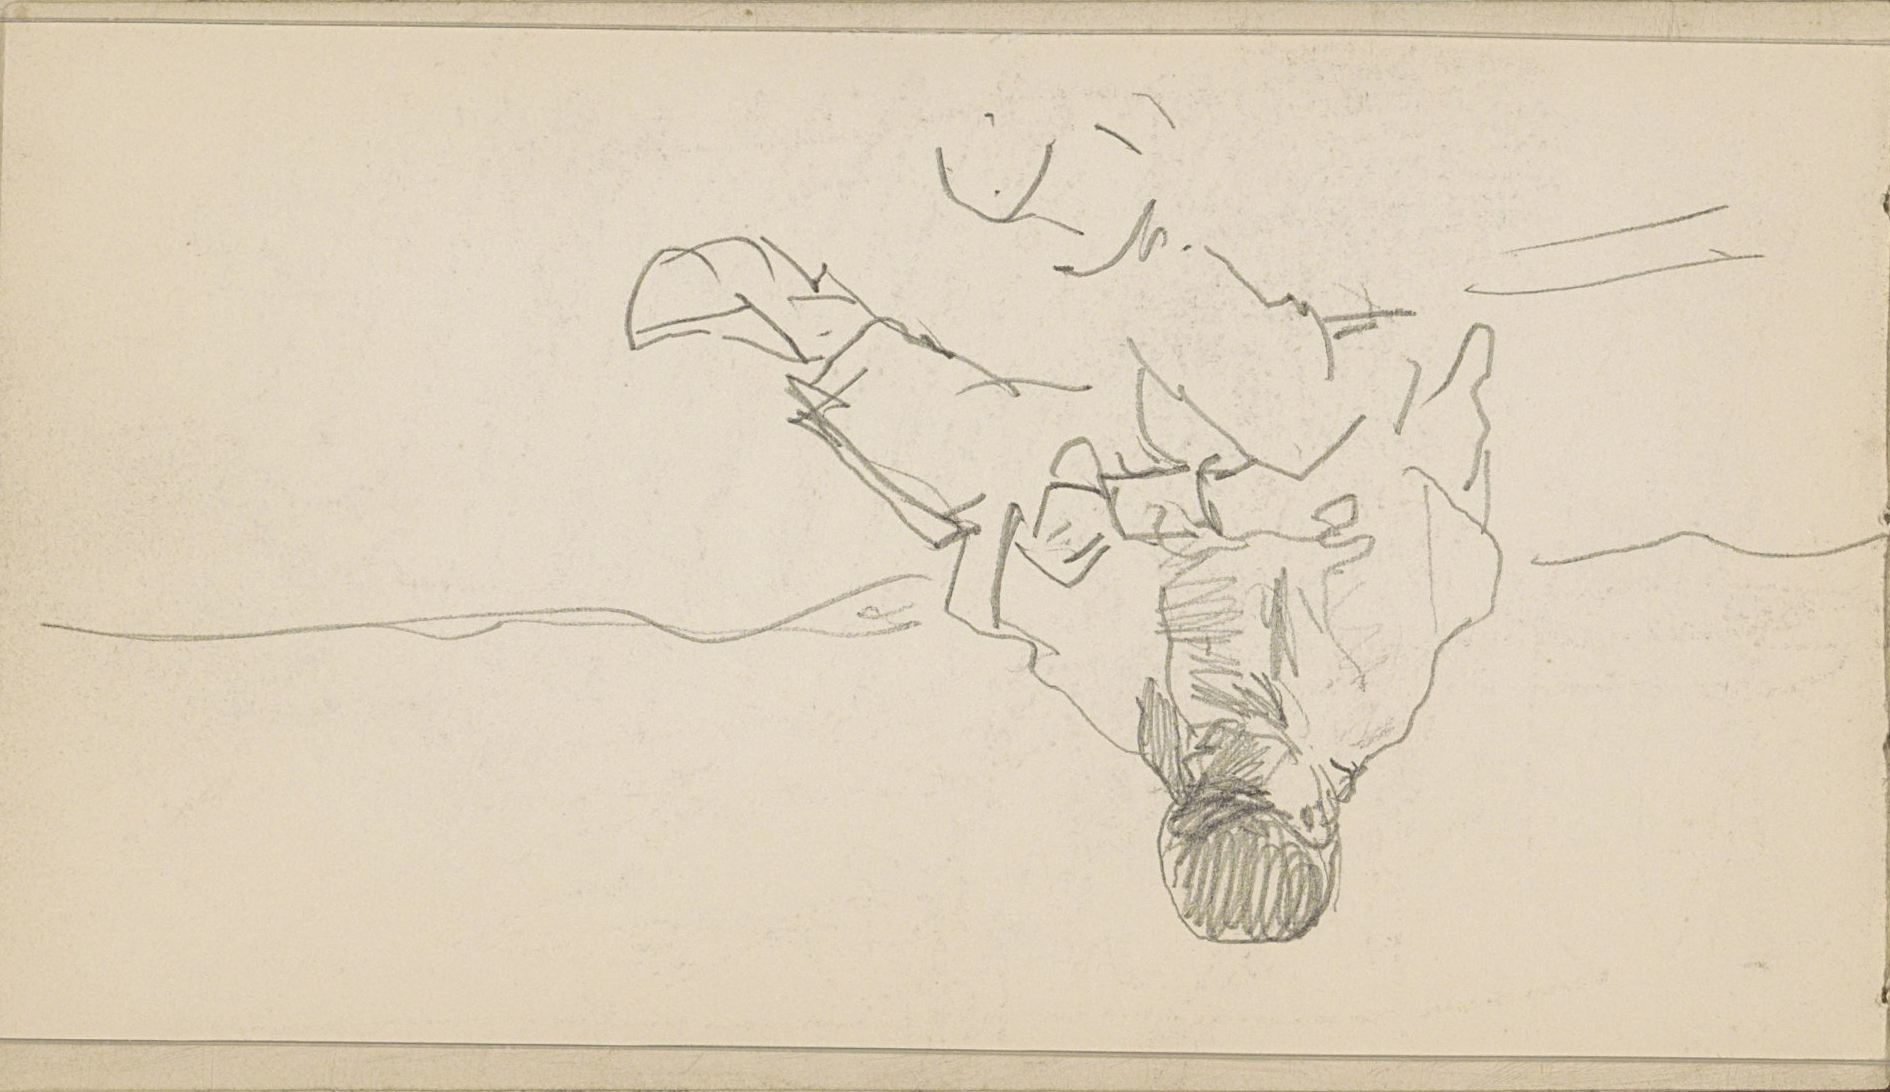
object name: sketchbook leaf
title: Zittende boer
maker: anton mauve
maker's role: draughtsman, painter, print maker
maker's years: 1838-1888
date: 1876-1879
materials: paper, pencil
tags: sitting figure, farmers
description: Blad 25 verso uit een schetsboek met 33 bladen.